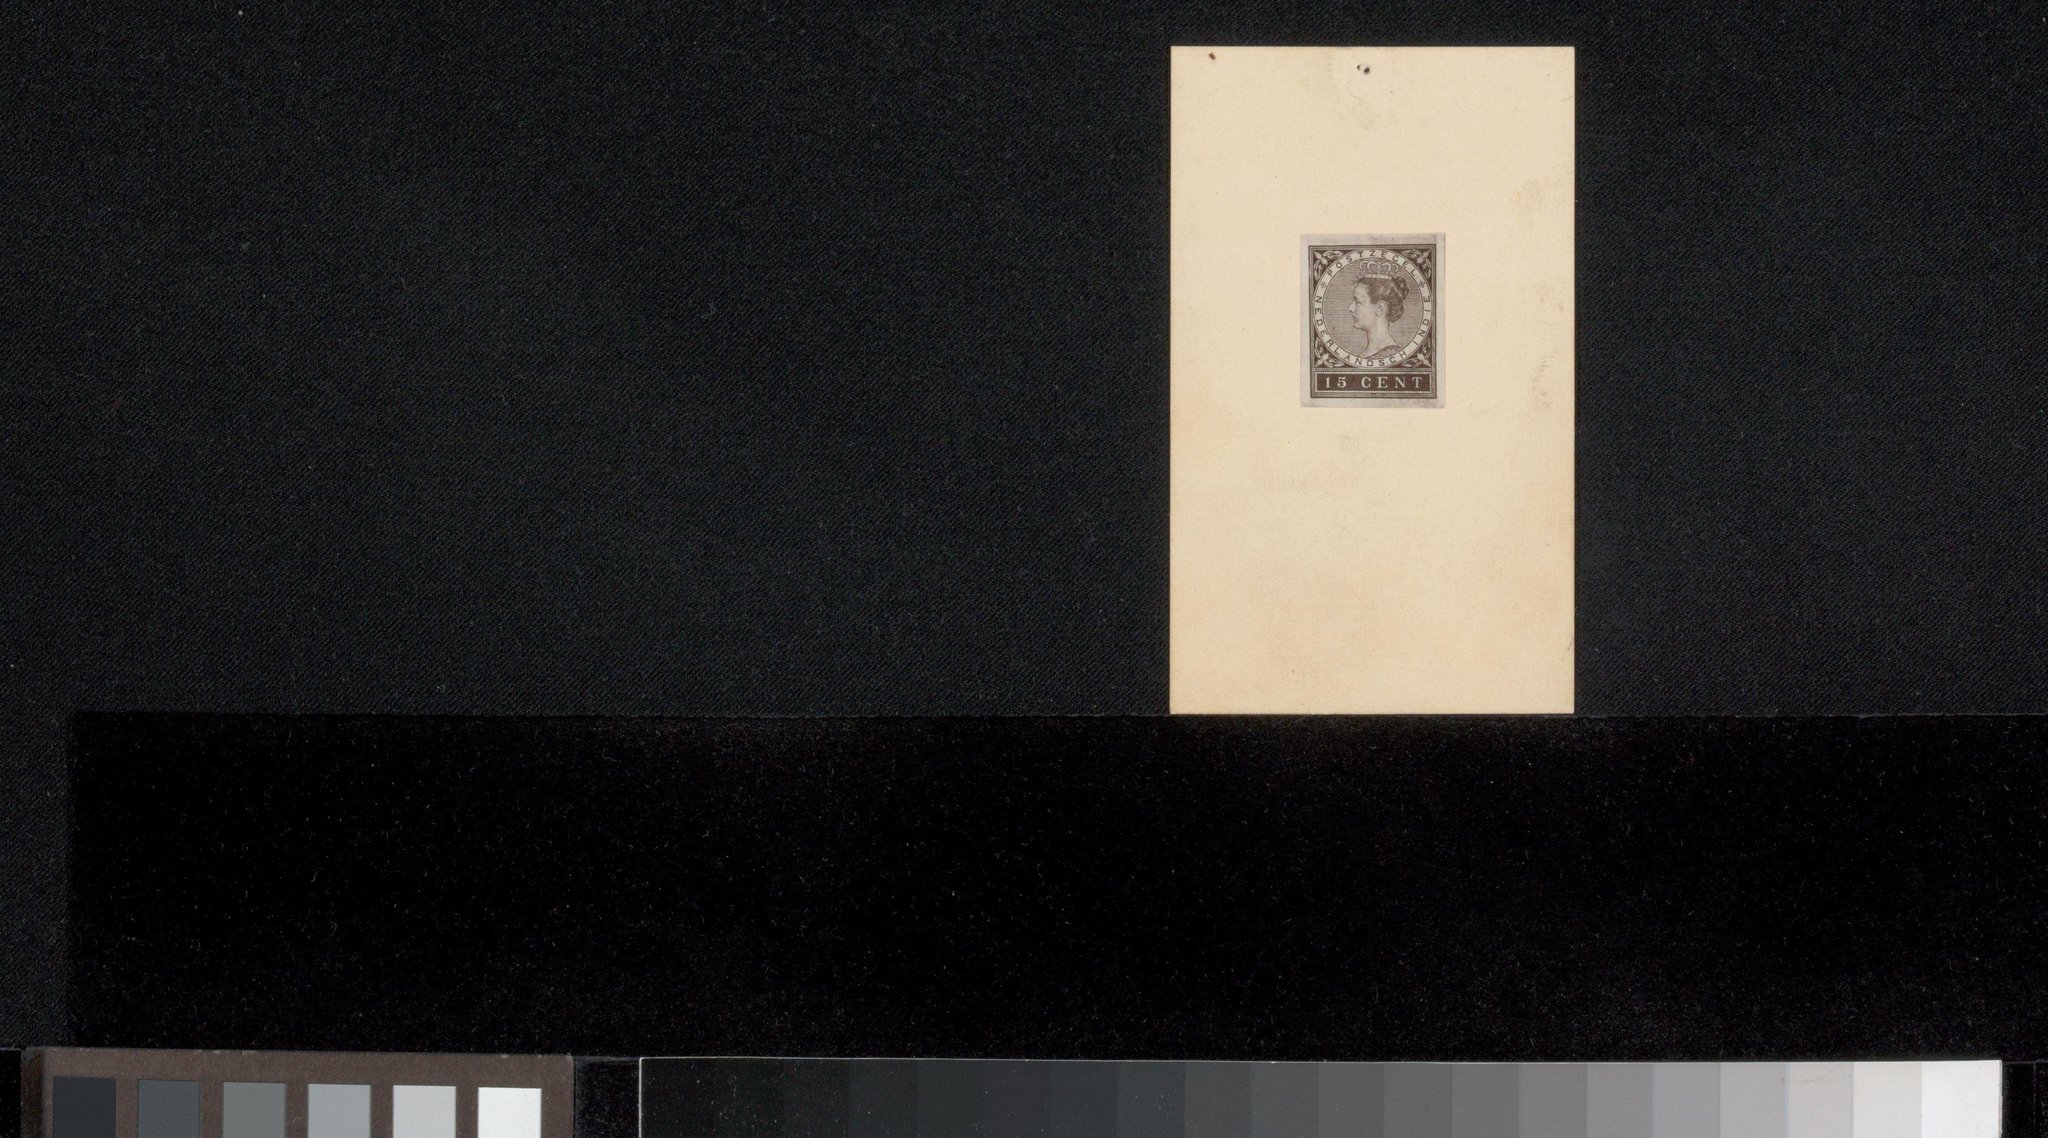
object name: postage stamp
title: Postzegel uit archief Jan Veth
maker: Anonymous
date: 1924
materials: ink, paper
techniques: printing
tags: wilhelmina of the netherlands, dordrecht, painter, print maker, draughtsman, designer, jan veth, historical persons (portraits and scenes from the life), dutch east indies, the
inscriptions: collector's mark: ‘RPK’